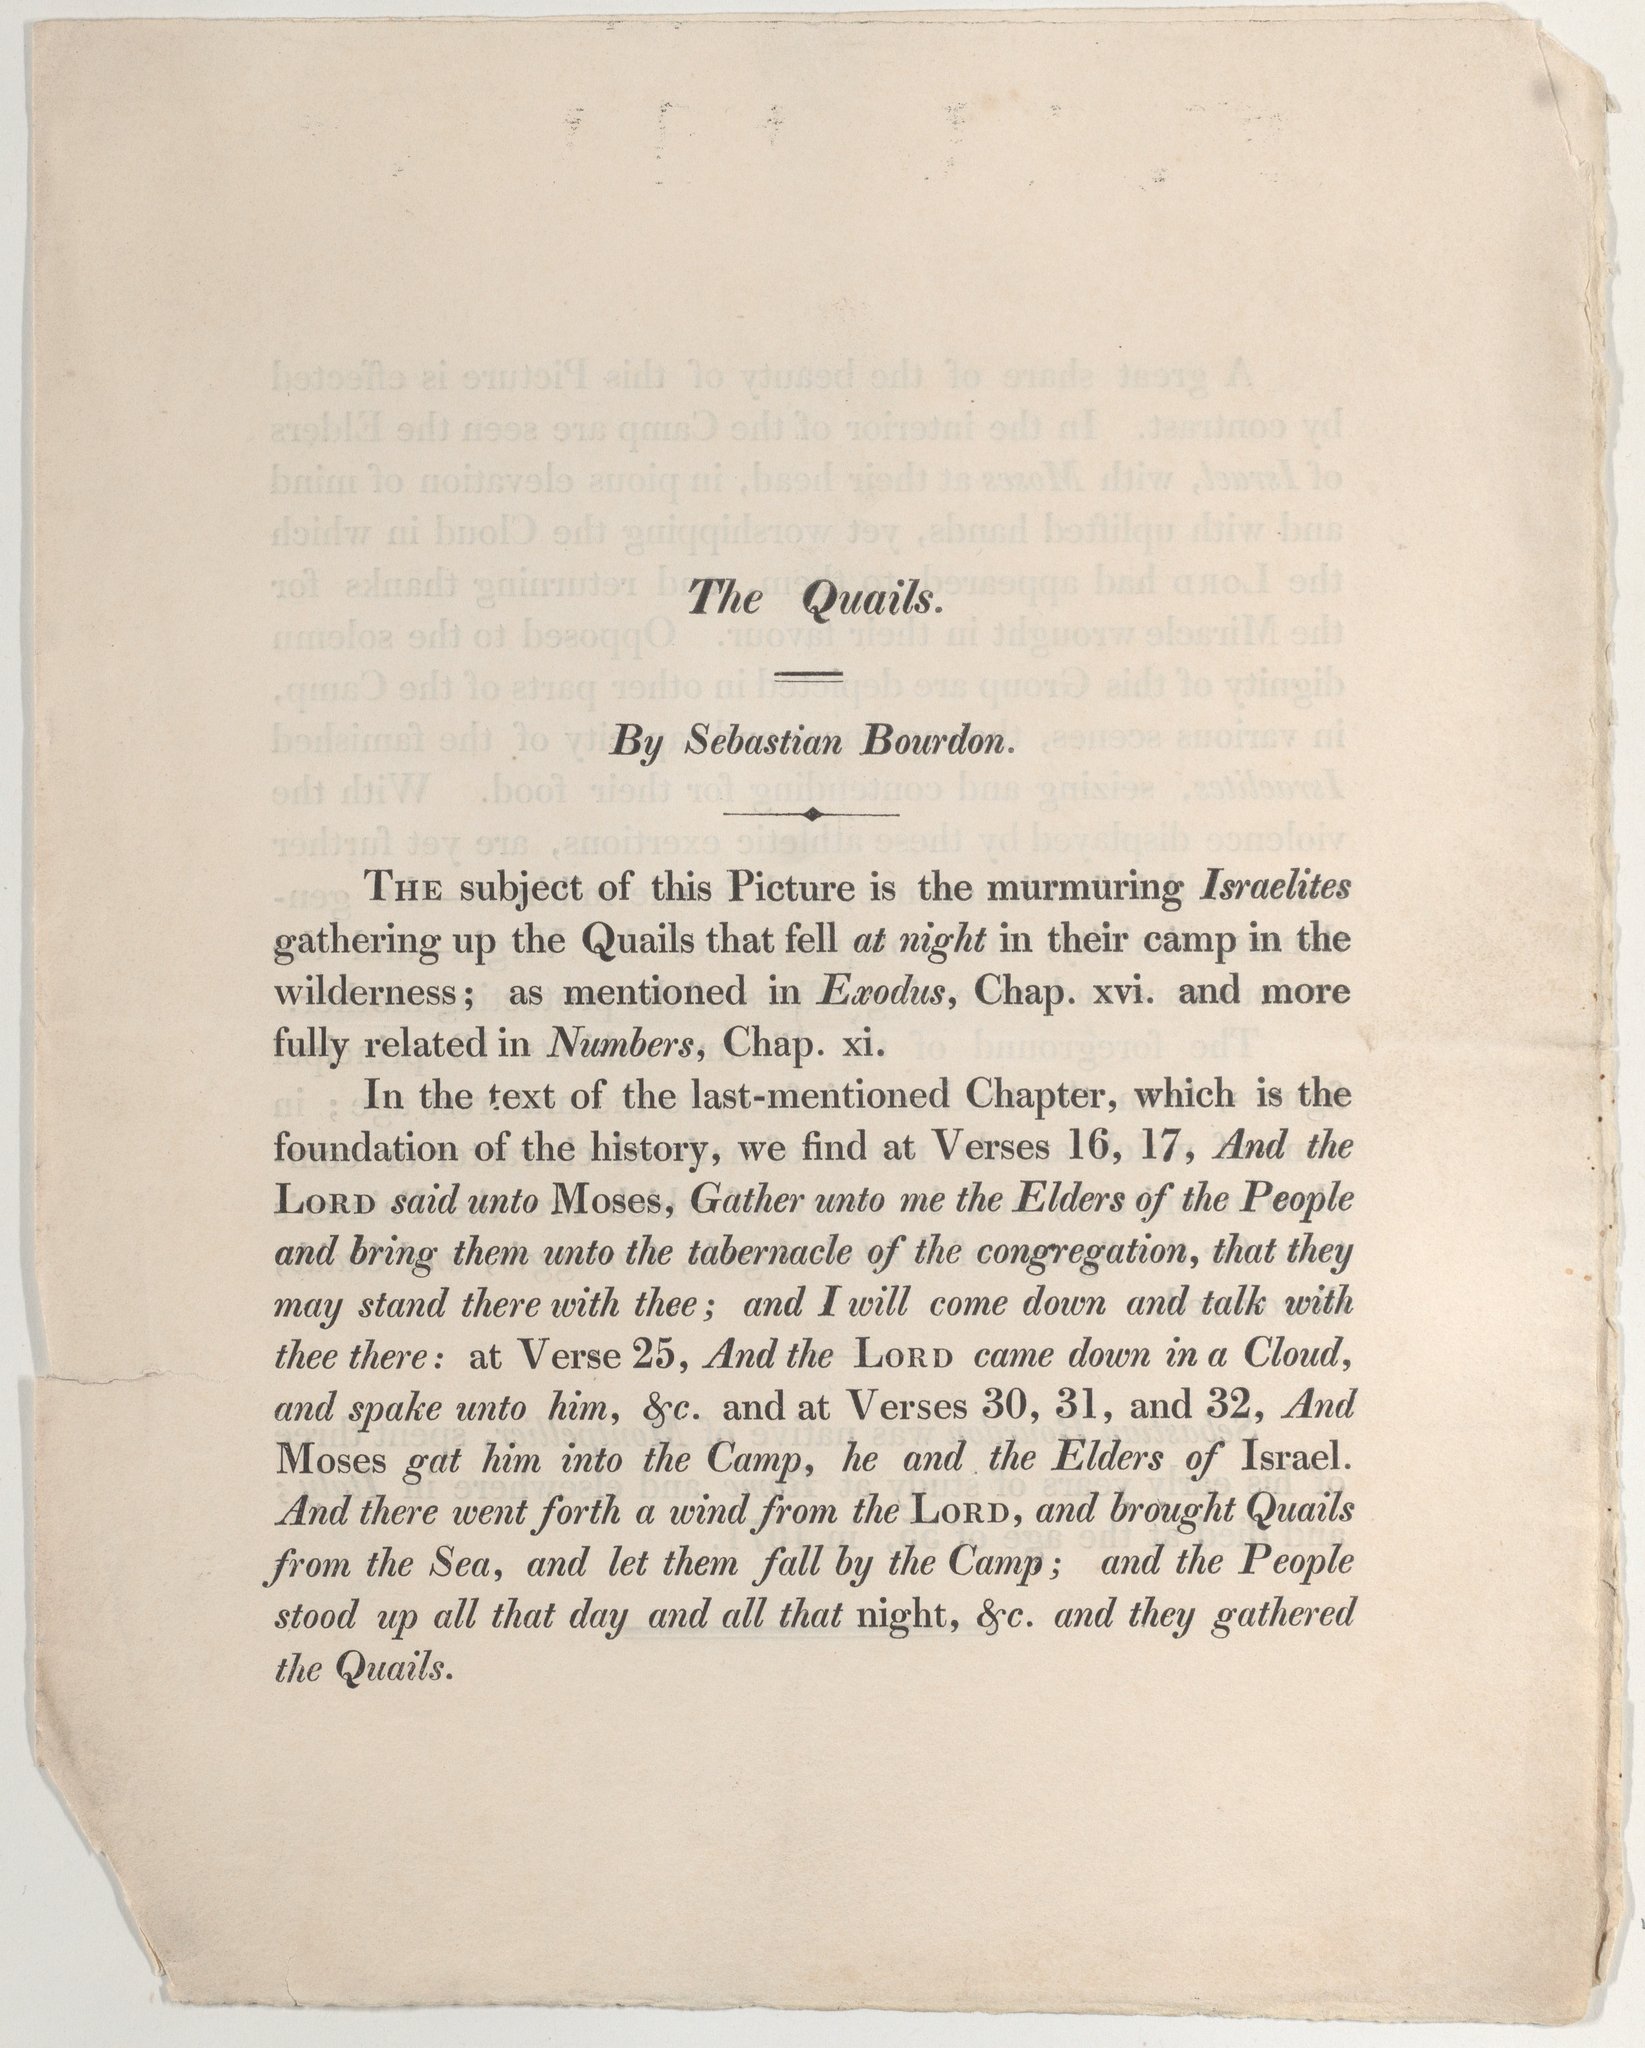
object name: print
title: Sheet with "The Quails" by Sebastian Bourdon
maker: anonymous, british, 18th century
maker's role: artist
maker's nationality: british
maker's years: 1700-1800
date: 1701-1800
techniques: letterpress